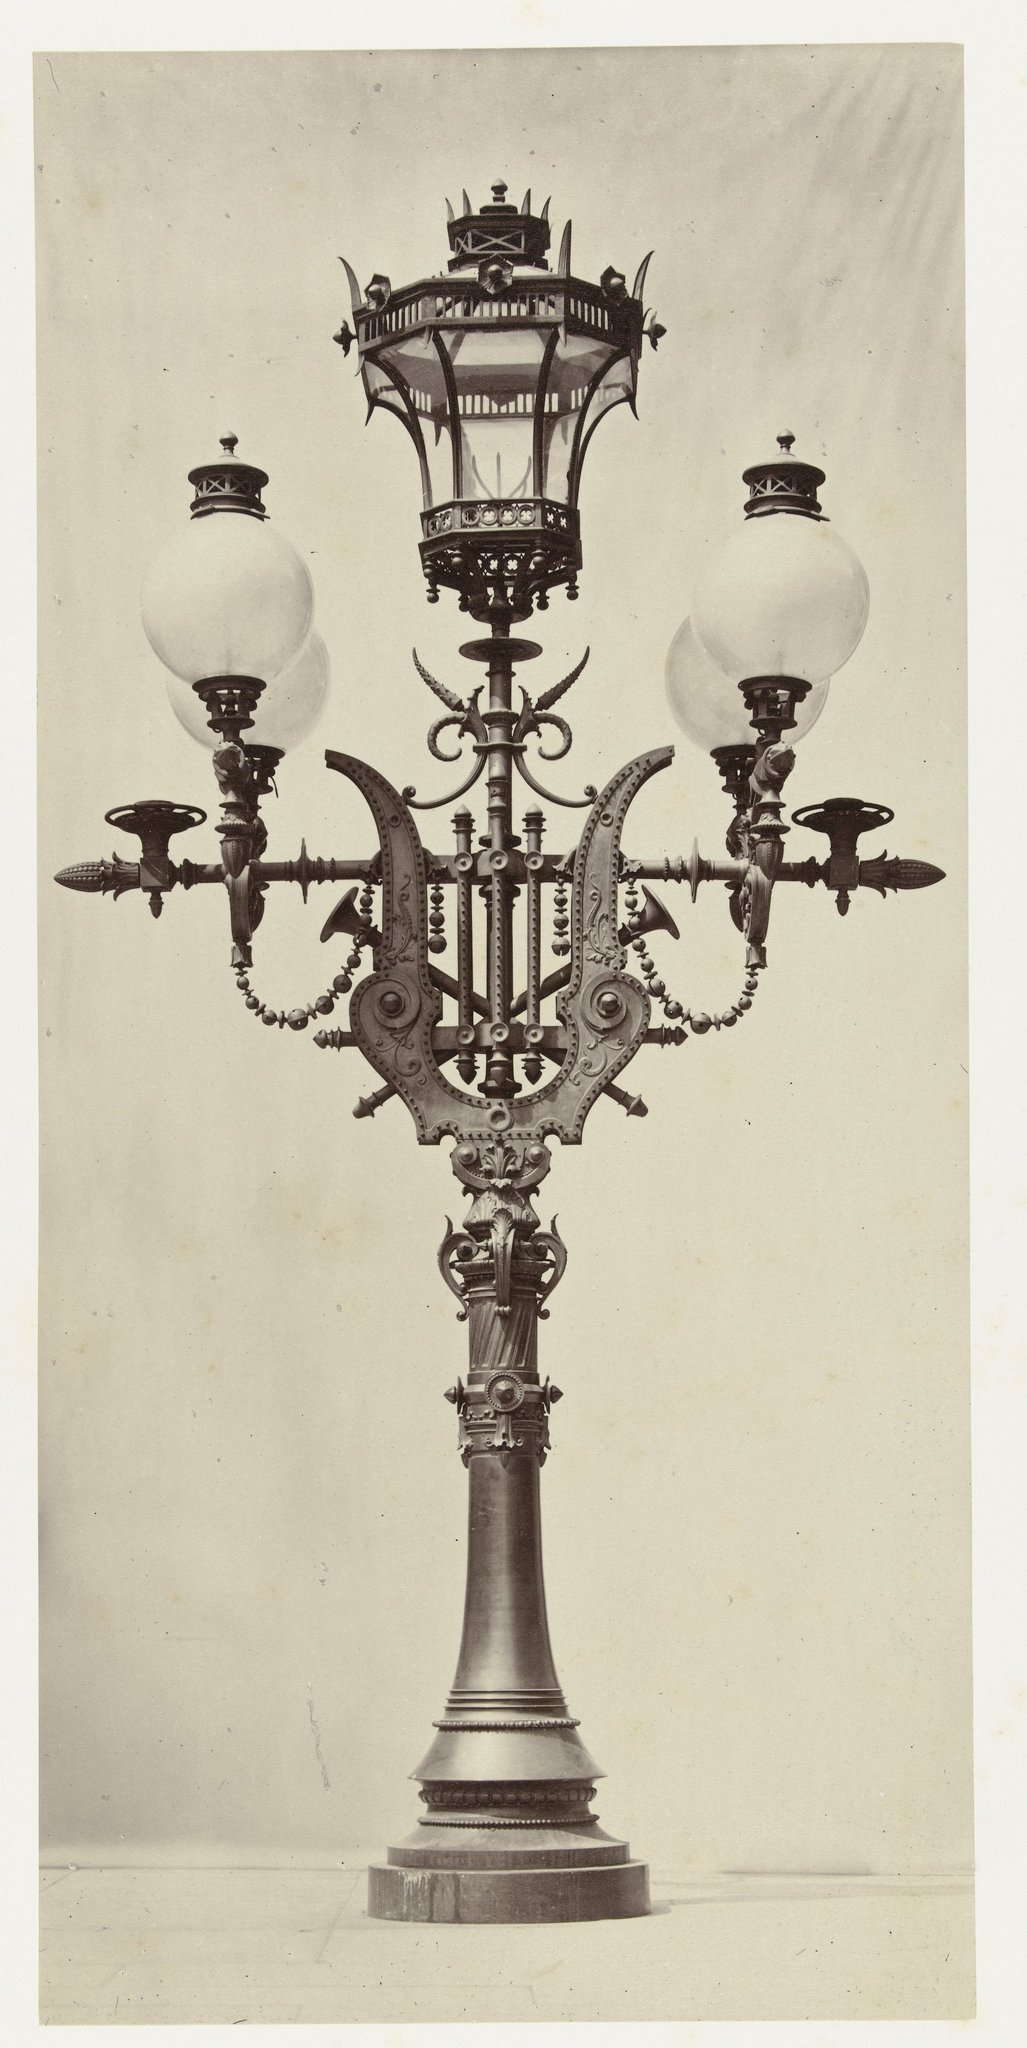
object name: photograph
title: Le Nouvel Opéra de Paris met 50 foto's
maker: louis-emile durandelle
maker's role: fotograaf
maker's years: 1839-1917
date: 1878-1881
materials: photographic support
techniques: gelatin silver print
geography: paris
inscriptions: number: ‘7’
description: Bij boek in Bibliotheek RMA, Zie Frizot, pp. 217-223, vgl G. Vicaire, Manuel de l'amateur de livres du XIXe siècle, vol. 3, column 870.